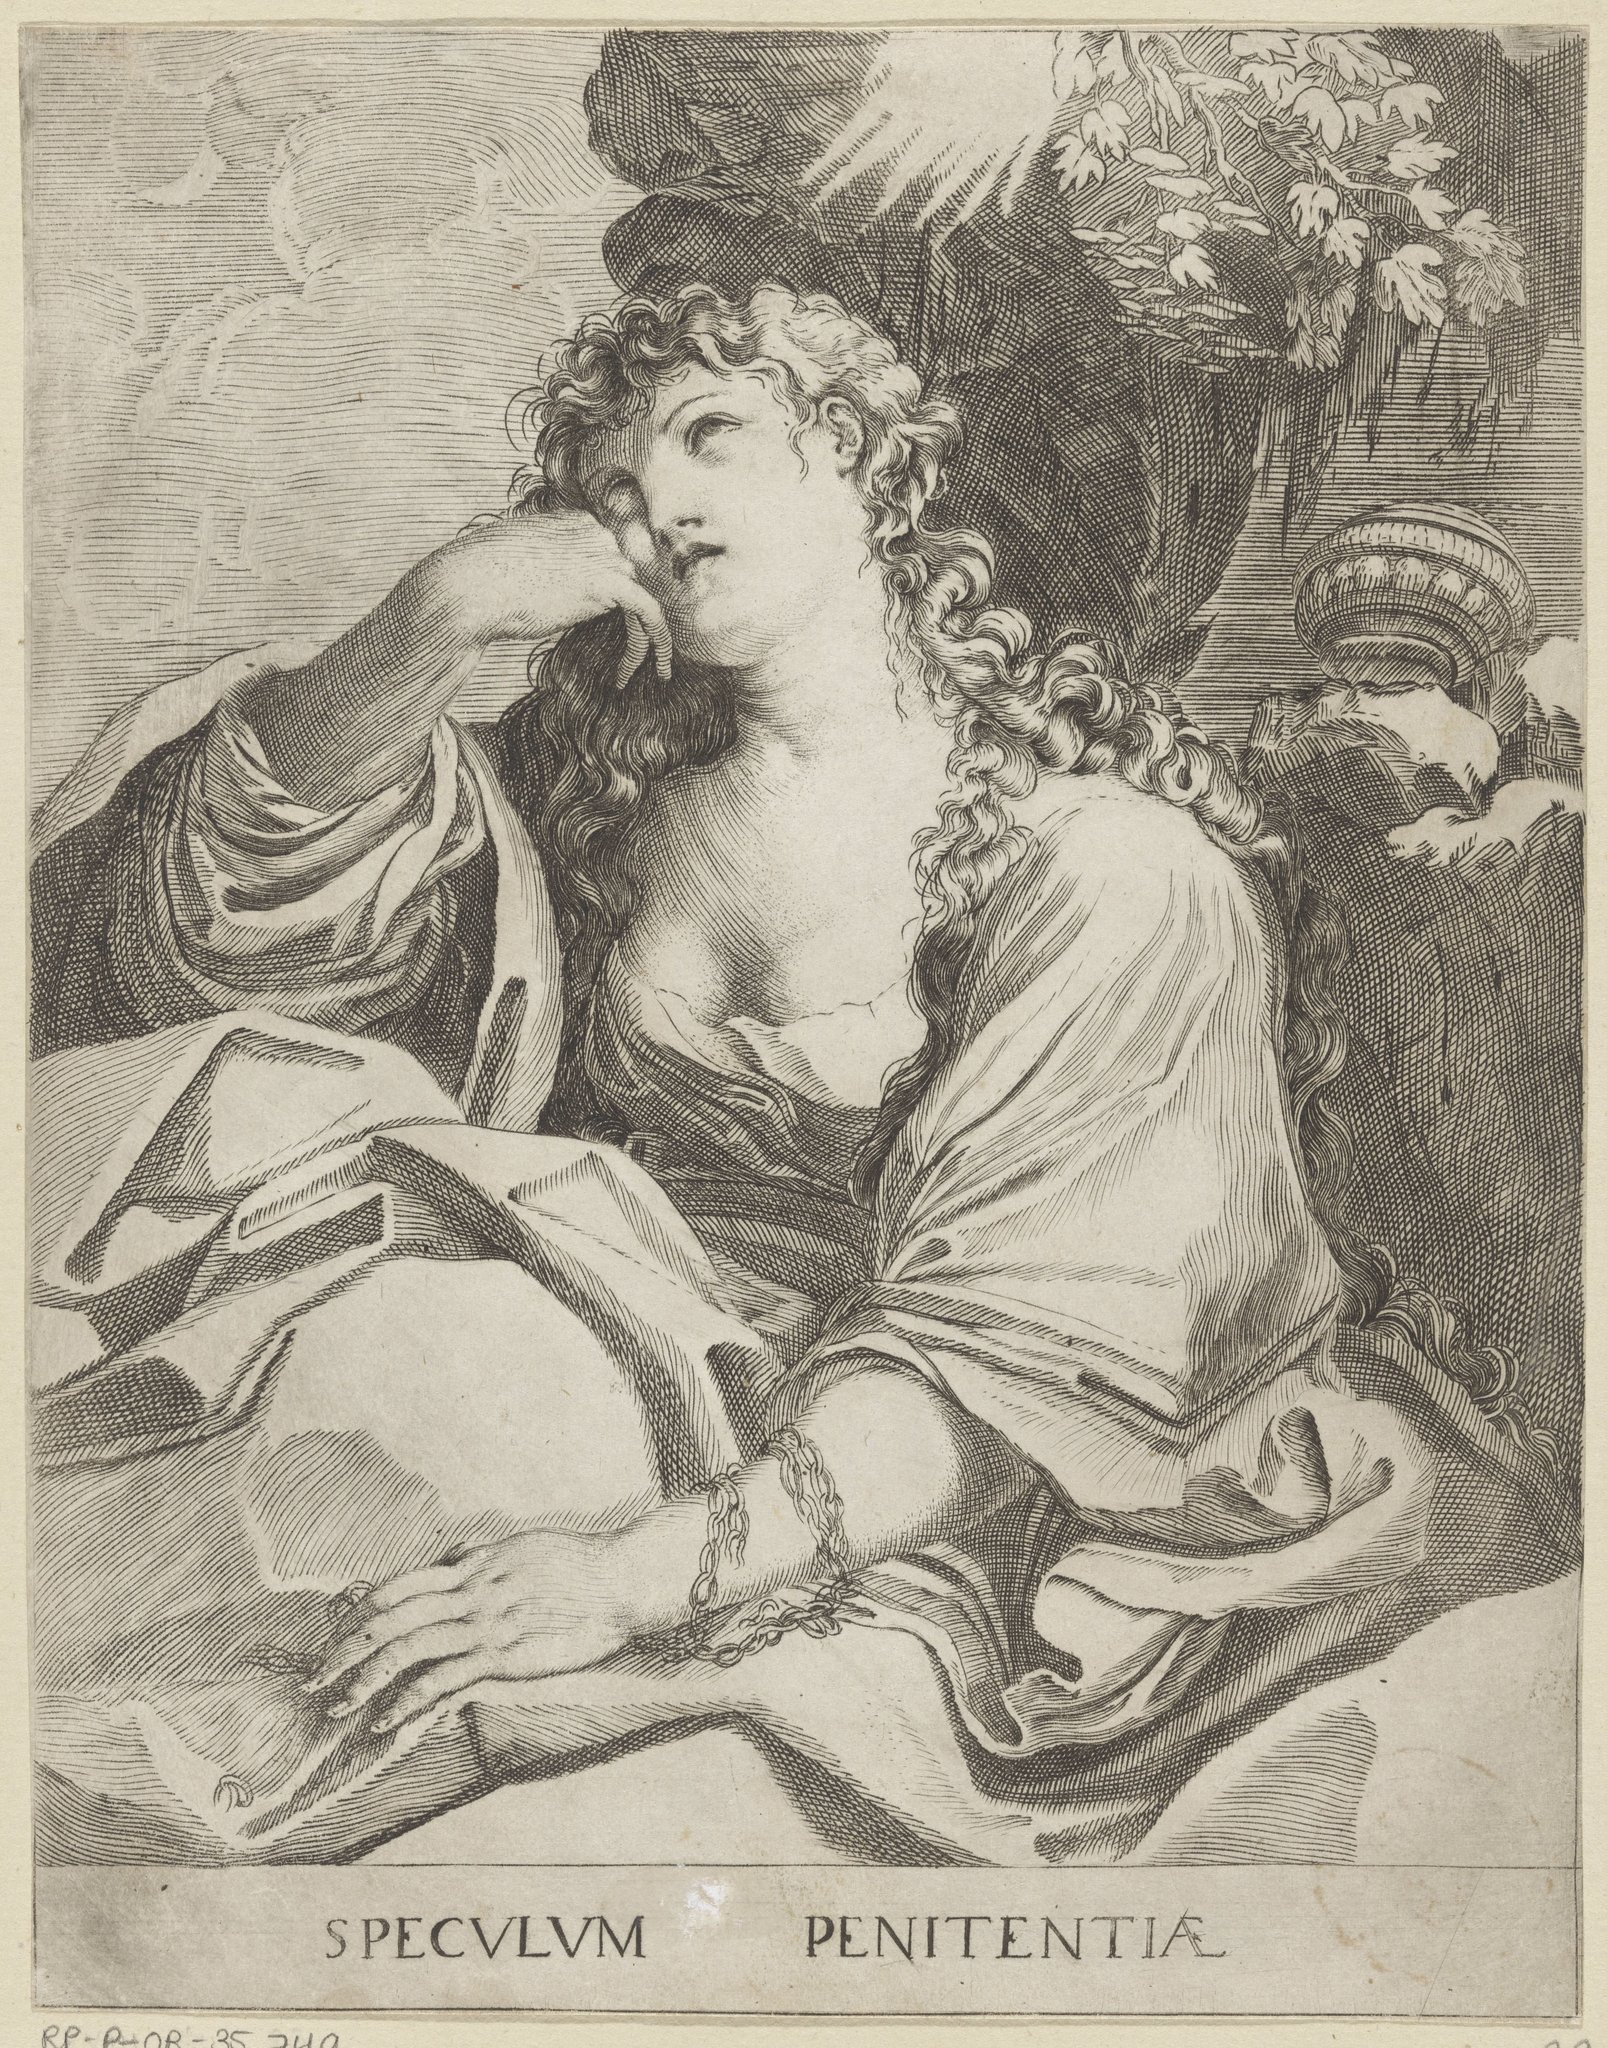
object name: print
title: Maria Magdalena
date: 1584-1623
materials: paper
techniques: engraving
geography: italy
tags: the penitent harlot mary magdalene; possible attributes: book (or scroll), crown, crown of thorns, crucifix, jar of ointment, mirror, musical instrument, palm-branch, rosary, scourge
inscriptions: collector's mark: Lugt 240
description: Maria Magdalena in een landschap. Op de achtergrond rechts staat een zalfpot.